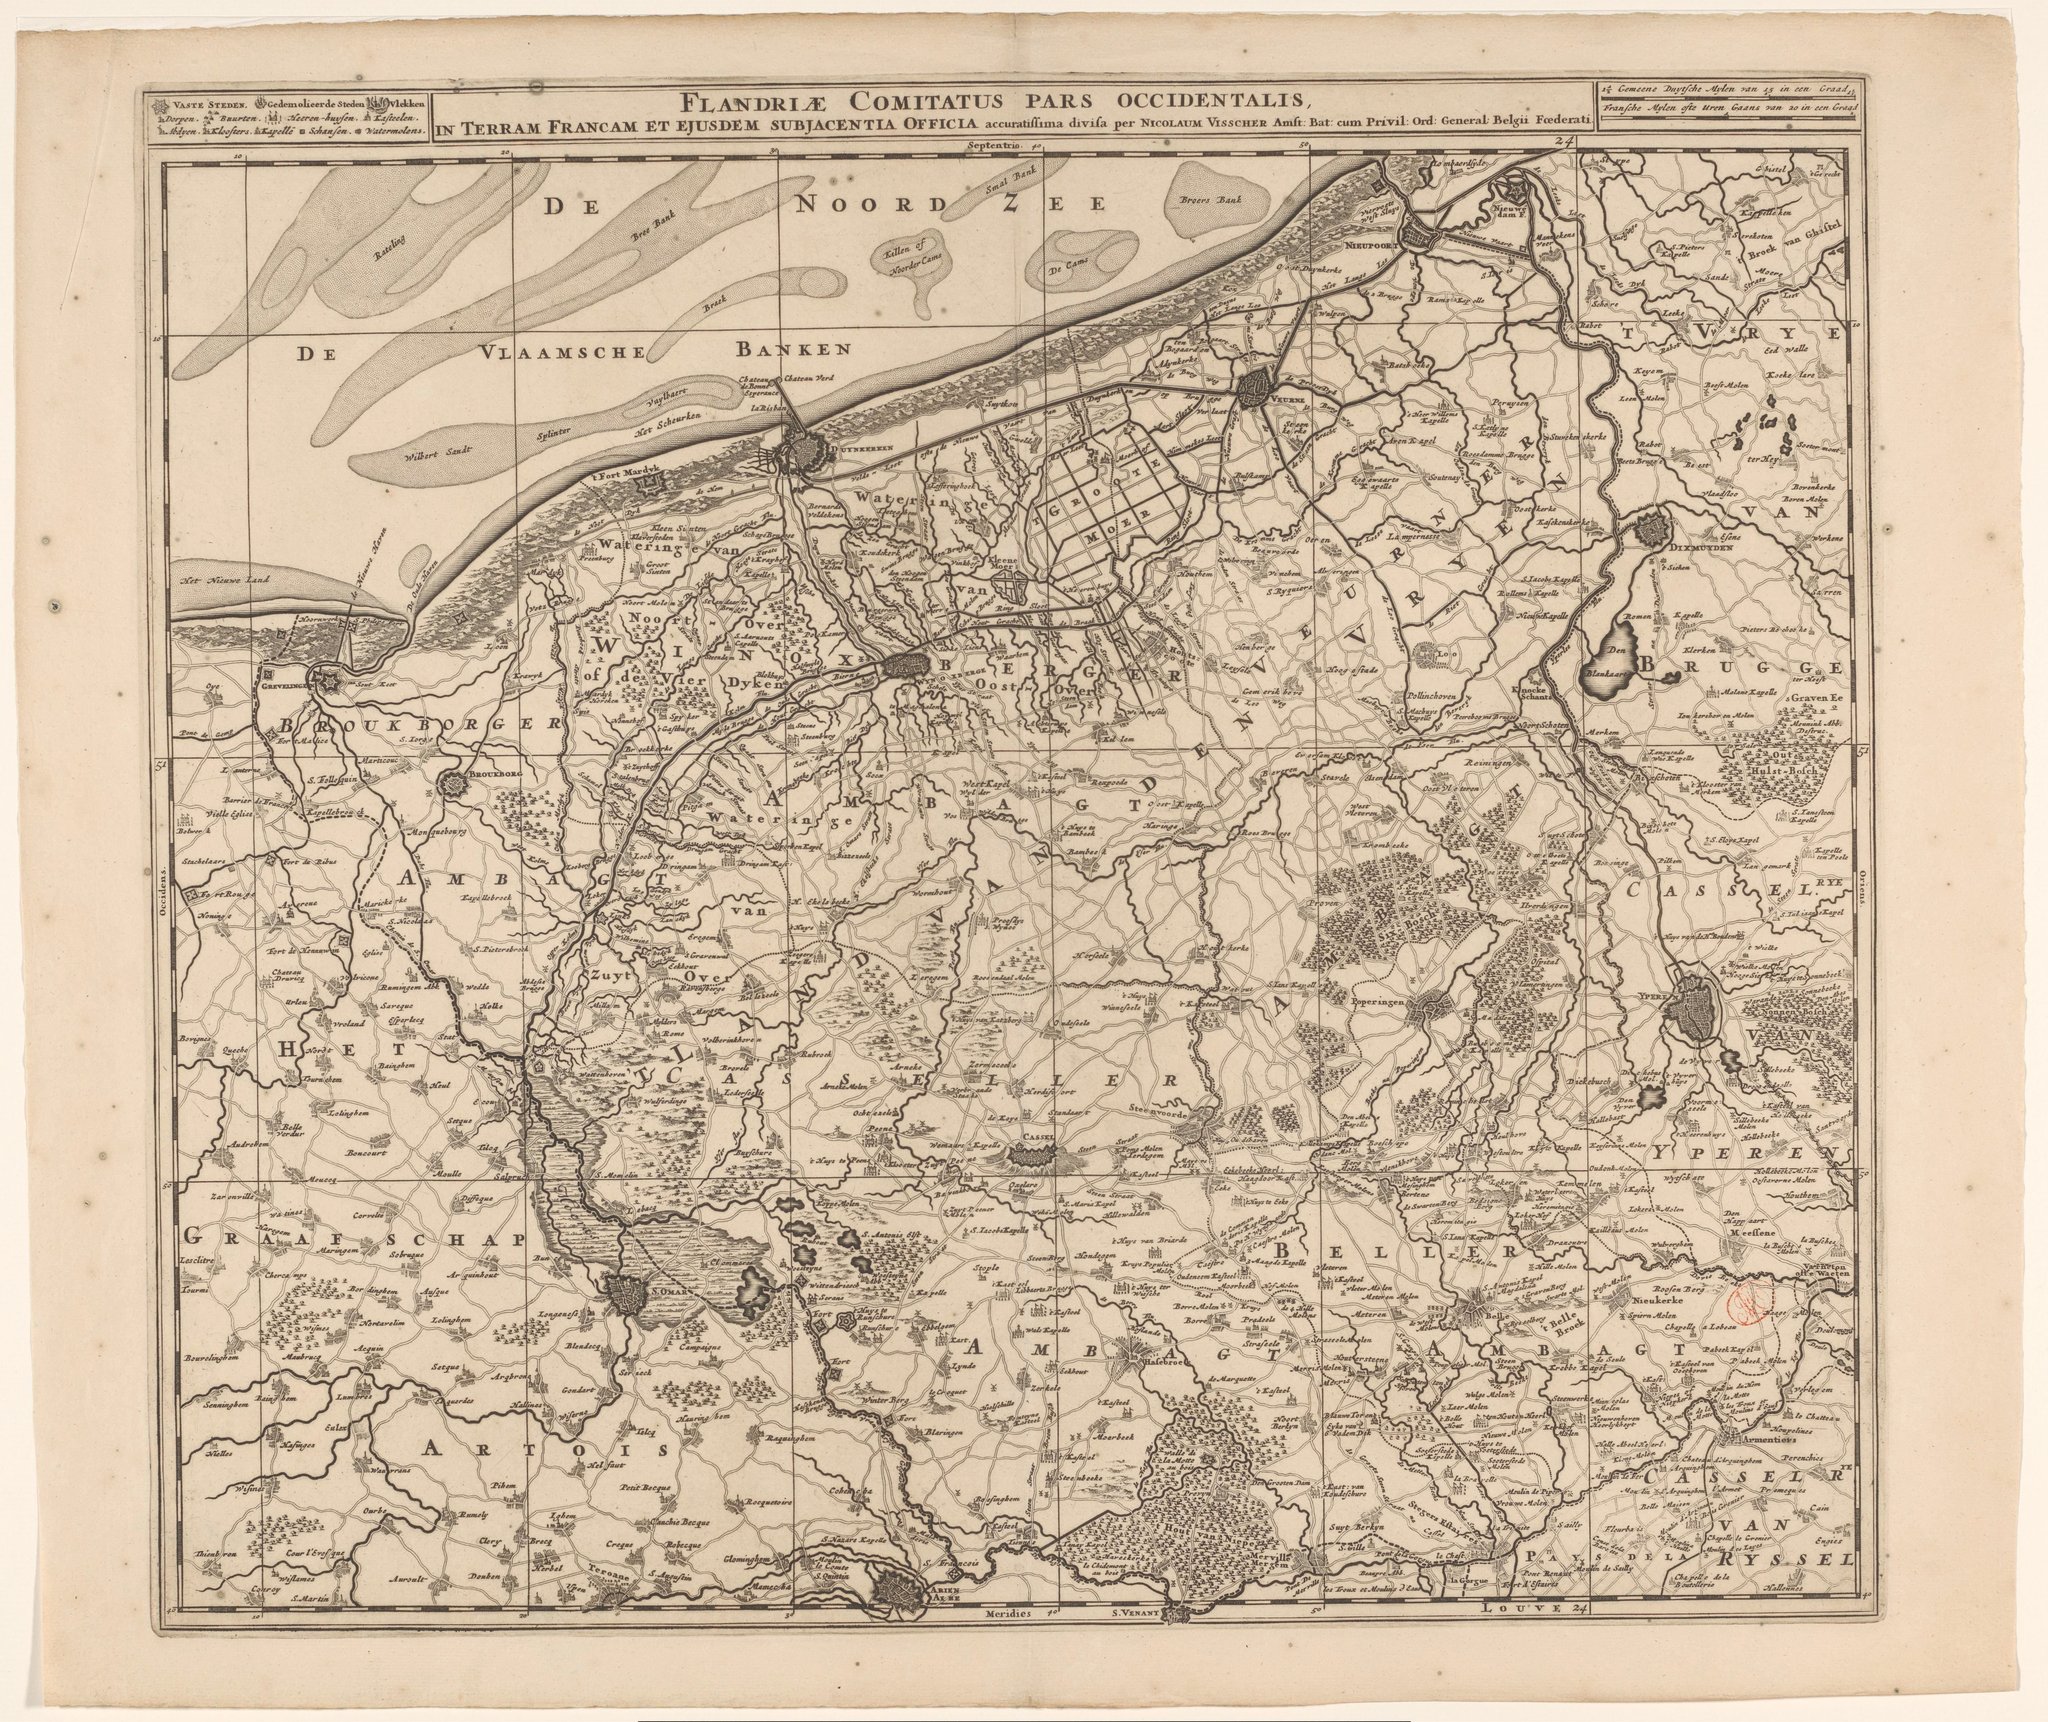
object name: print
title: Kaart van het westelijk deel van Vlaanderen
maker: Anonymous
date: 1677-1720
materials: paper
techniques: engraving, etching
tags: maps of separate countries or regions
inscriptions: collector's mark: Lugt 195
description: Kaart van het westelijk deel van Vlaanderen. In een balk boven de kaart, in het midden, de titel. Links hiervan een legenda. Rechts van de titel twee schaalstokken: 1 1/2 Gemeene Duytsche Mijlen van 15 in een Graad / 2 Fransche Mylen ofte Uren Gaans van 20 in een Graad. De kaart is voorzien van een coördinaten-net en een gradenverdeling.